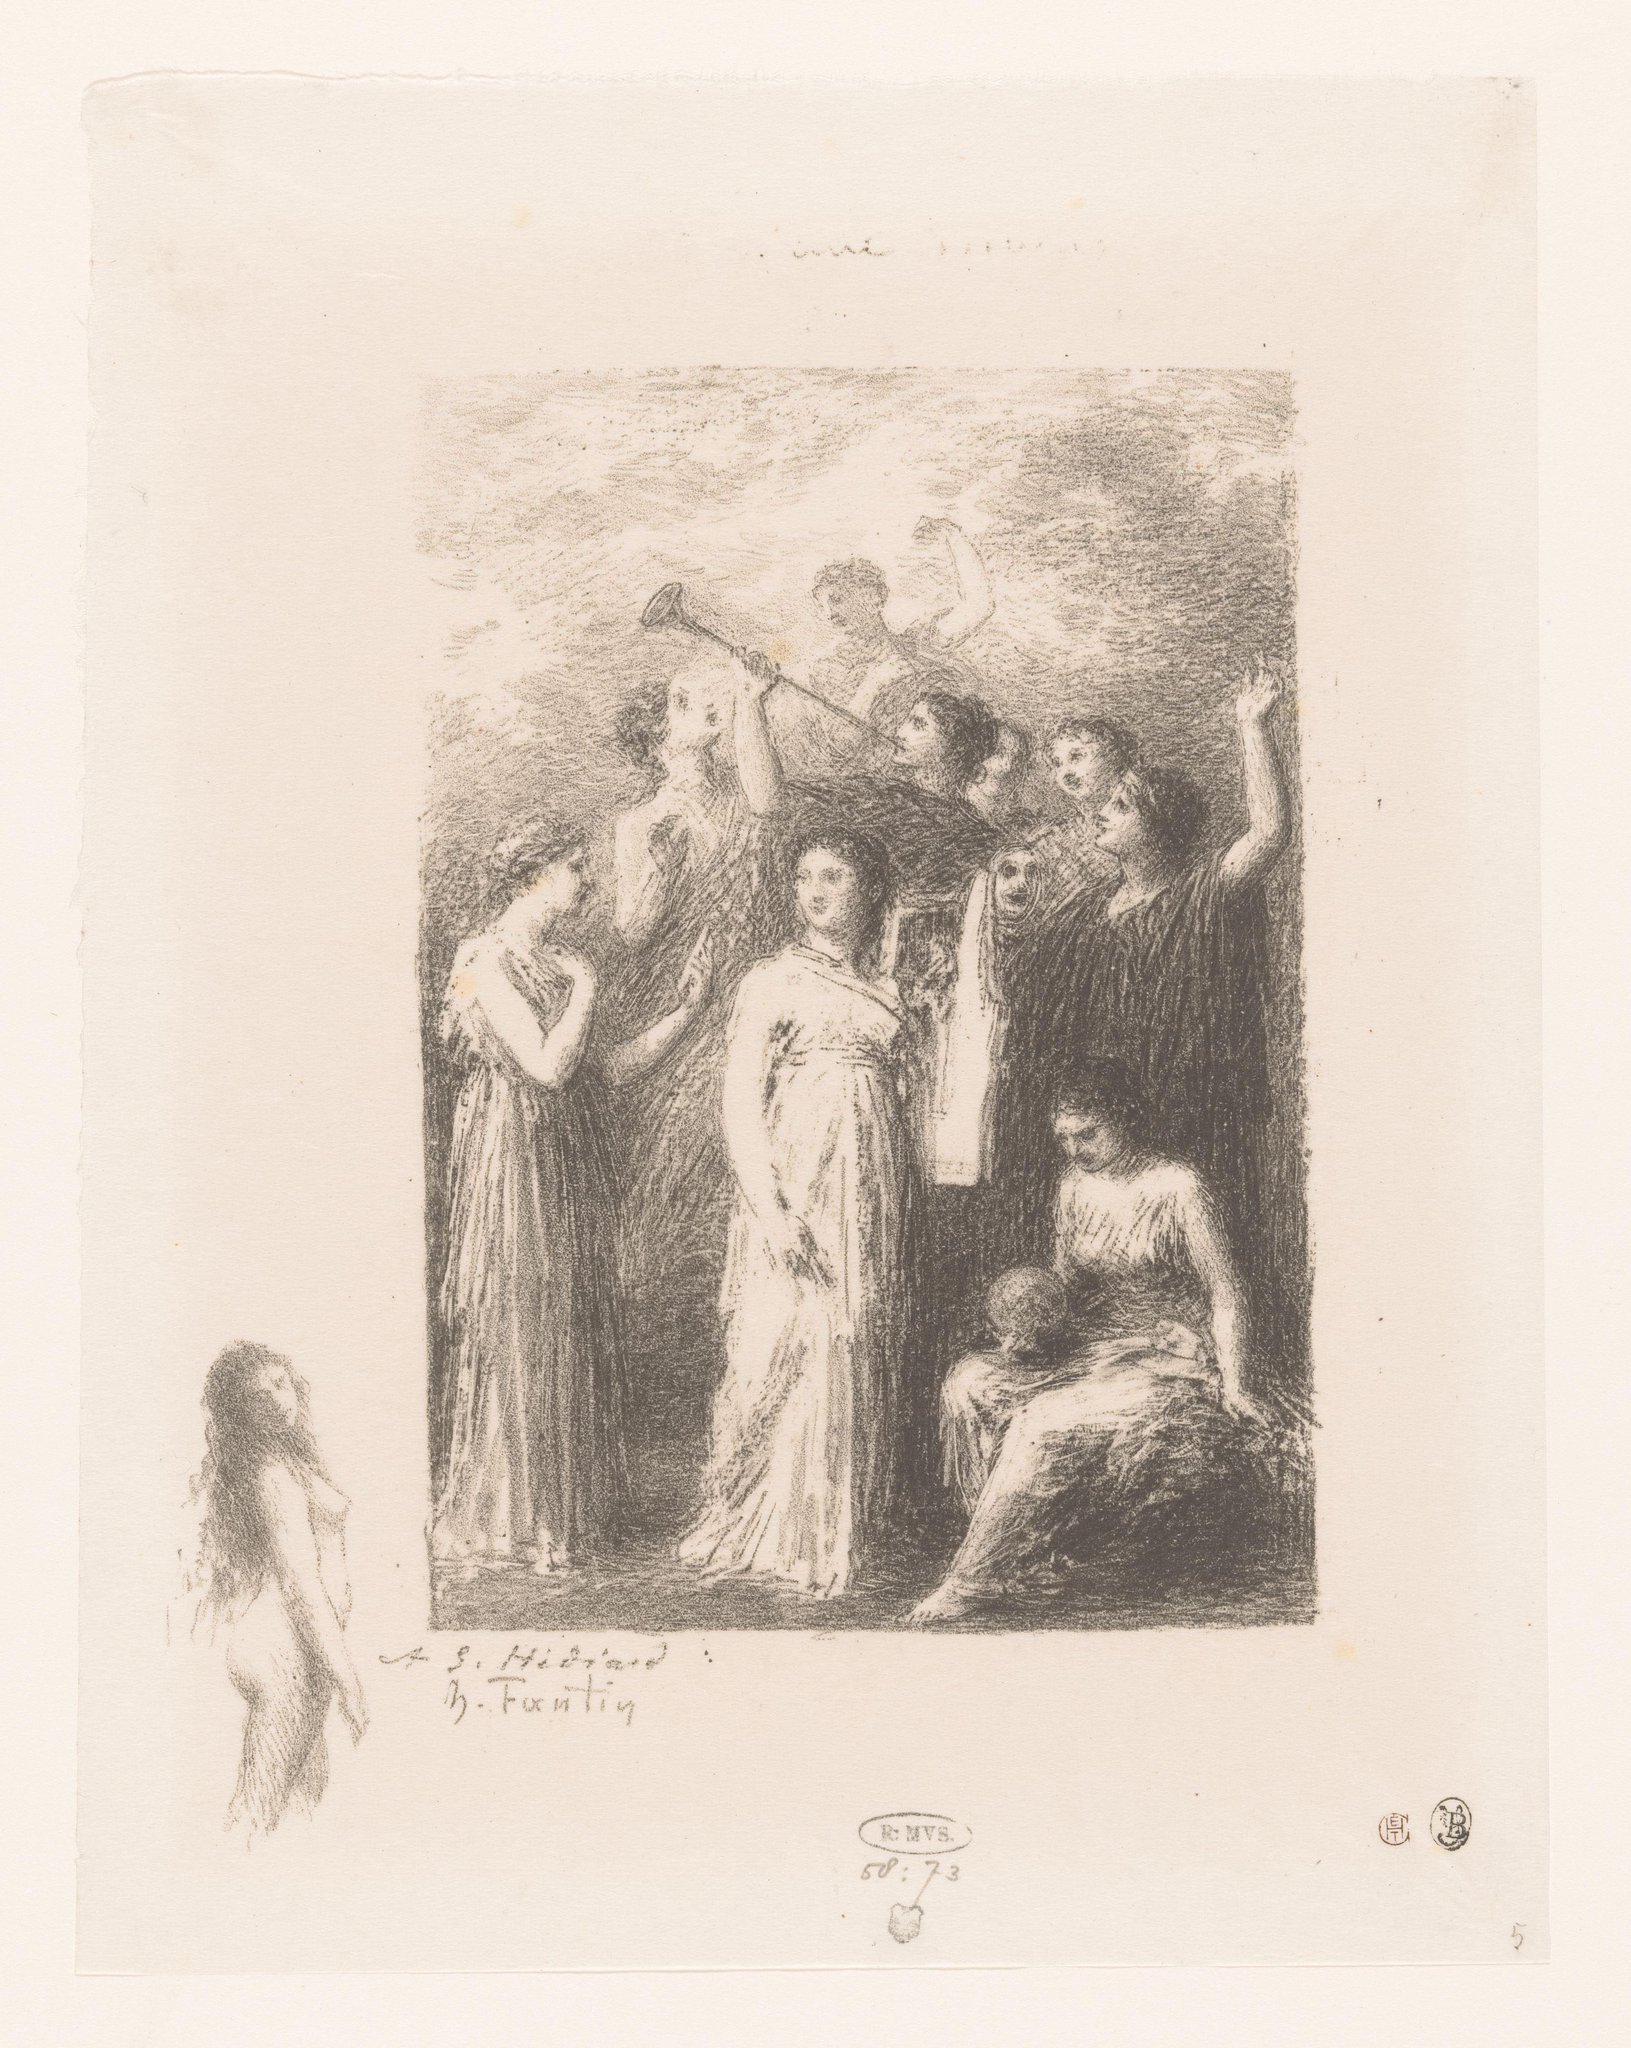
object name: print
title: Frontispice: L'Aveugle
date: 1905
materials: paper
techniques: lithography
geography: paris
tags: the muses acting together (as group) - attributes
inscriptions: collector's mark: Lugt 2228a, collector's mark: Lugt 421, collector's mark: Lugt 533b, collector's mark: Lugt 2760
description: Illustratie bij het gedicht L'Aveugle van André Chénier, specifiek de verzen: Venez à moi de l’Olympe habitantes, Muses; vous savez tout, vous déesses.